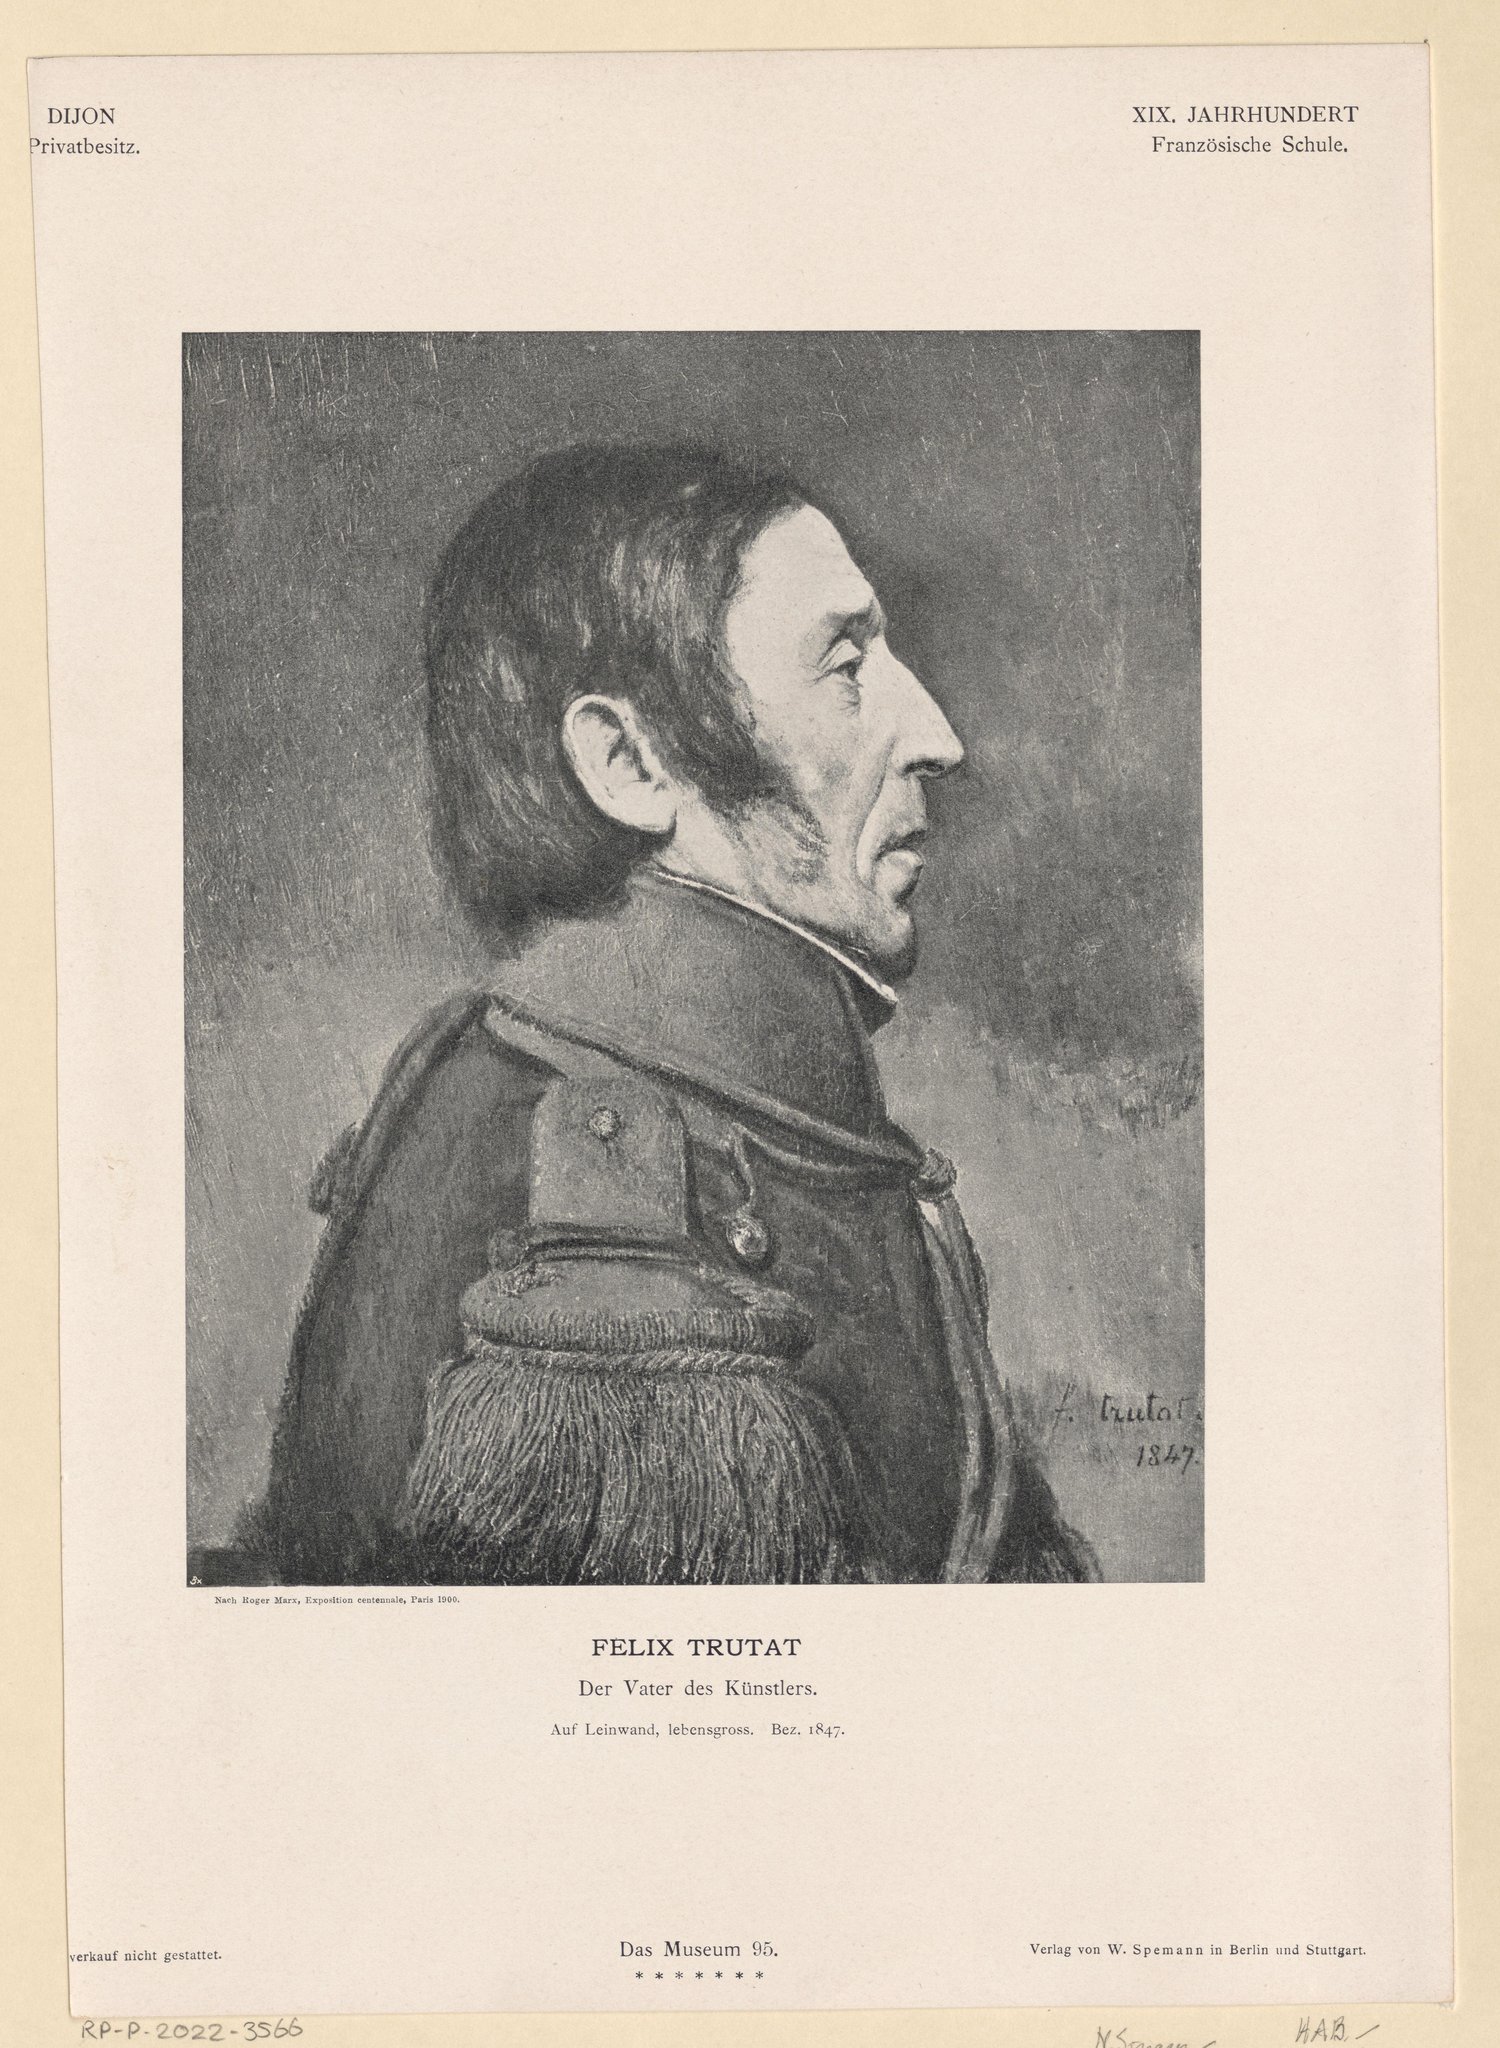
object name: photomechanical print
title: Portret van de vader van Félix Trutat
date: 1900-1910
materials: paper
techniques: autotype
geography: germany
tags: anonymous historical person portrayed alone